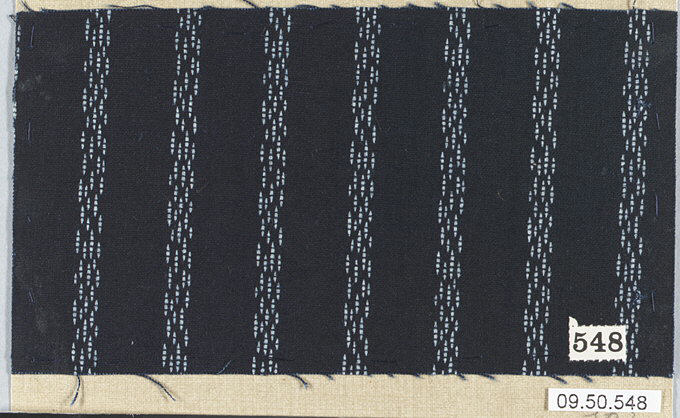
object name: piece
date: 1801-1900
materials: cotton